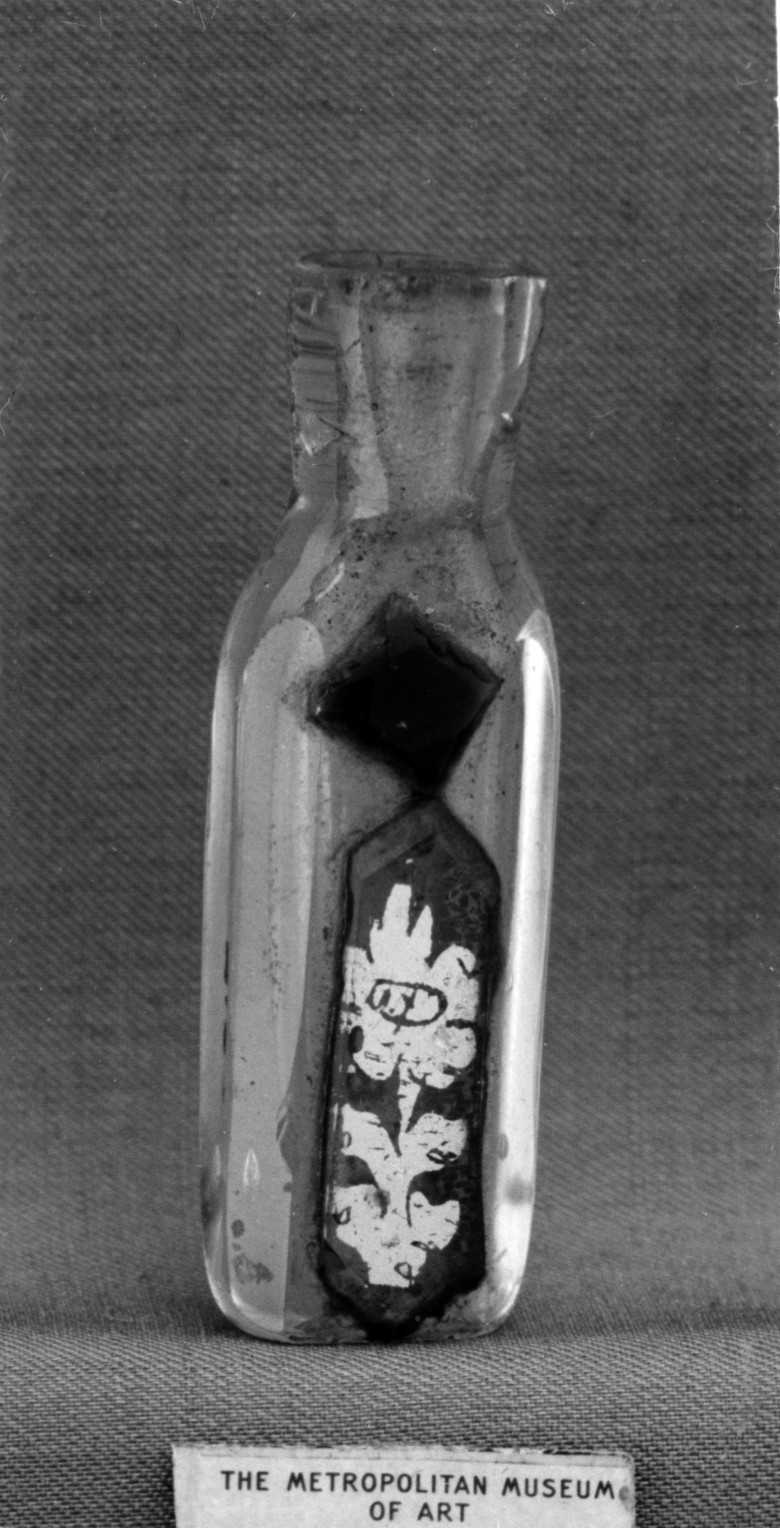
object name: bottle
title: Miniature bottle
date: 1701-1900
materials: glass